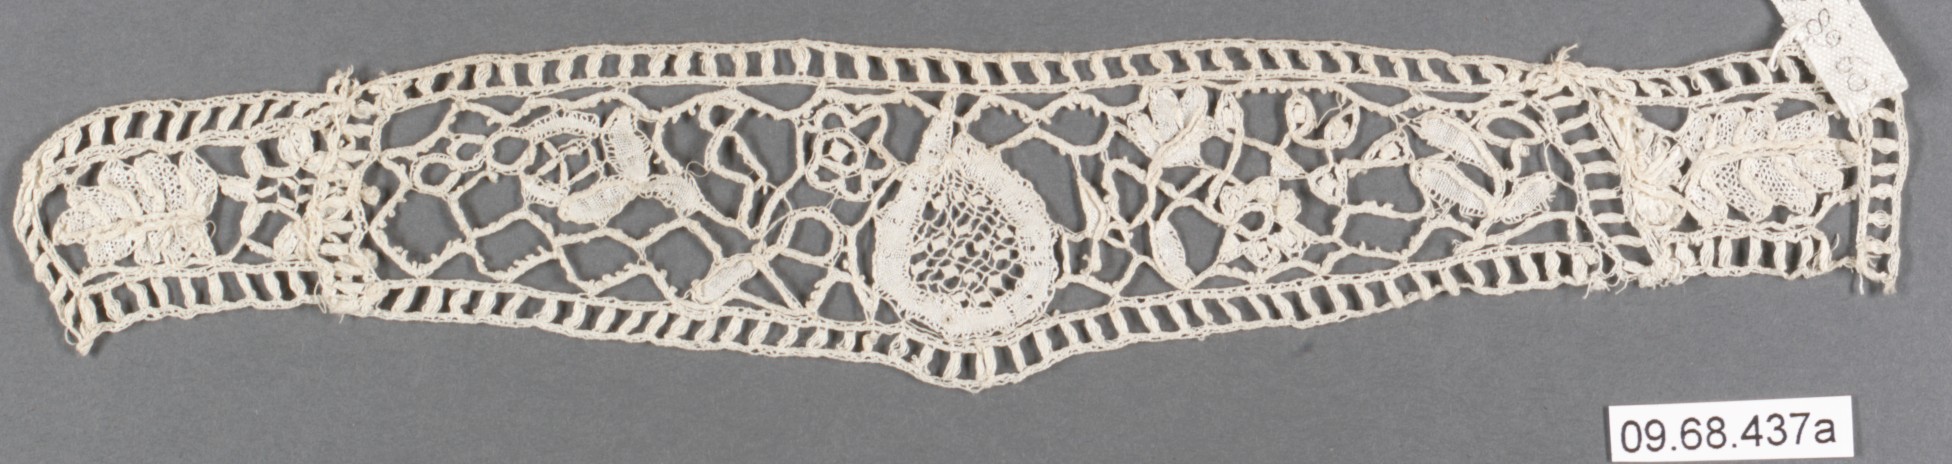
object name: cuff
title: Cuff (one of a pair)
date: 1801-1900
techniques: lace